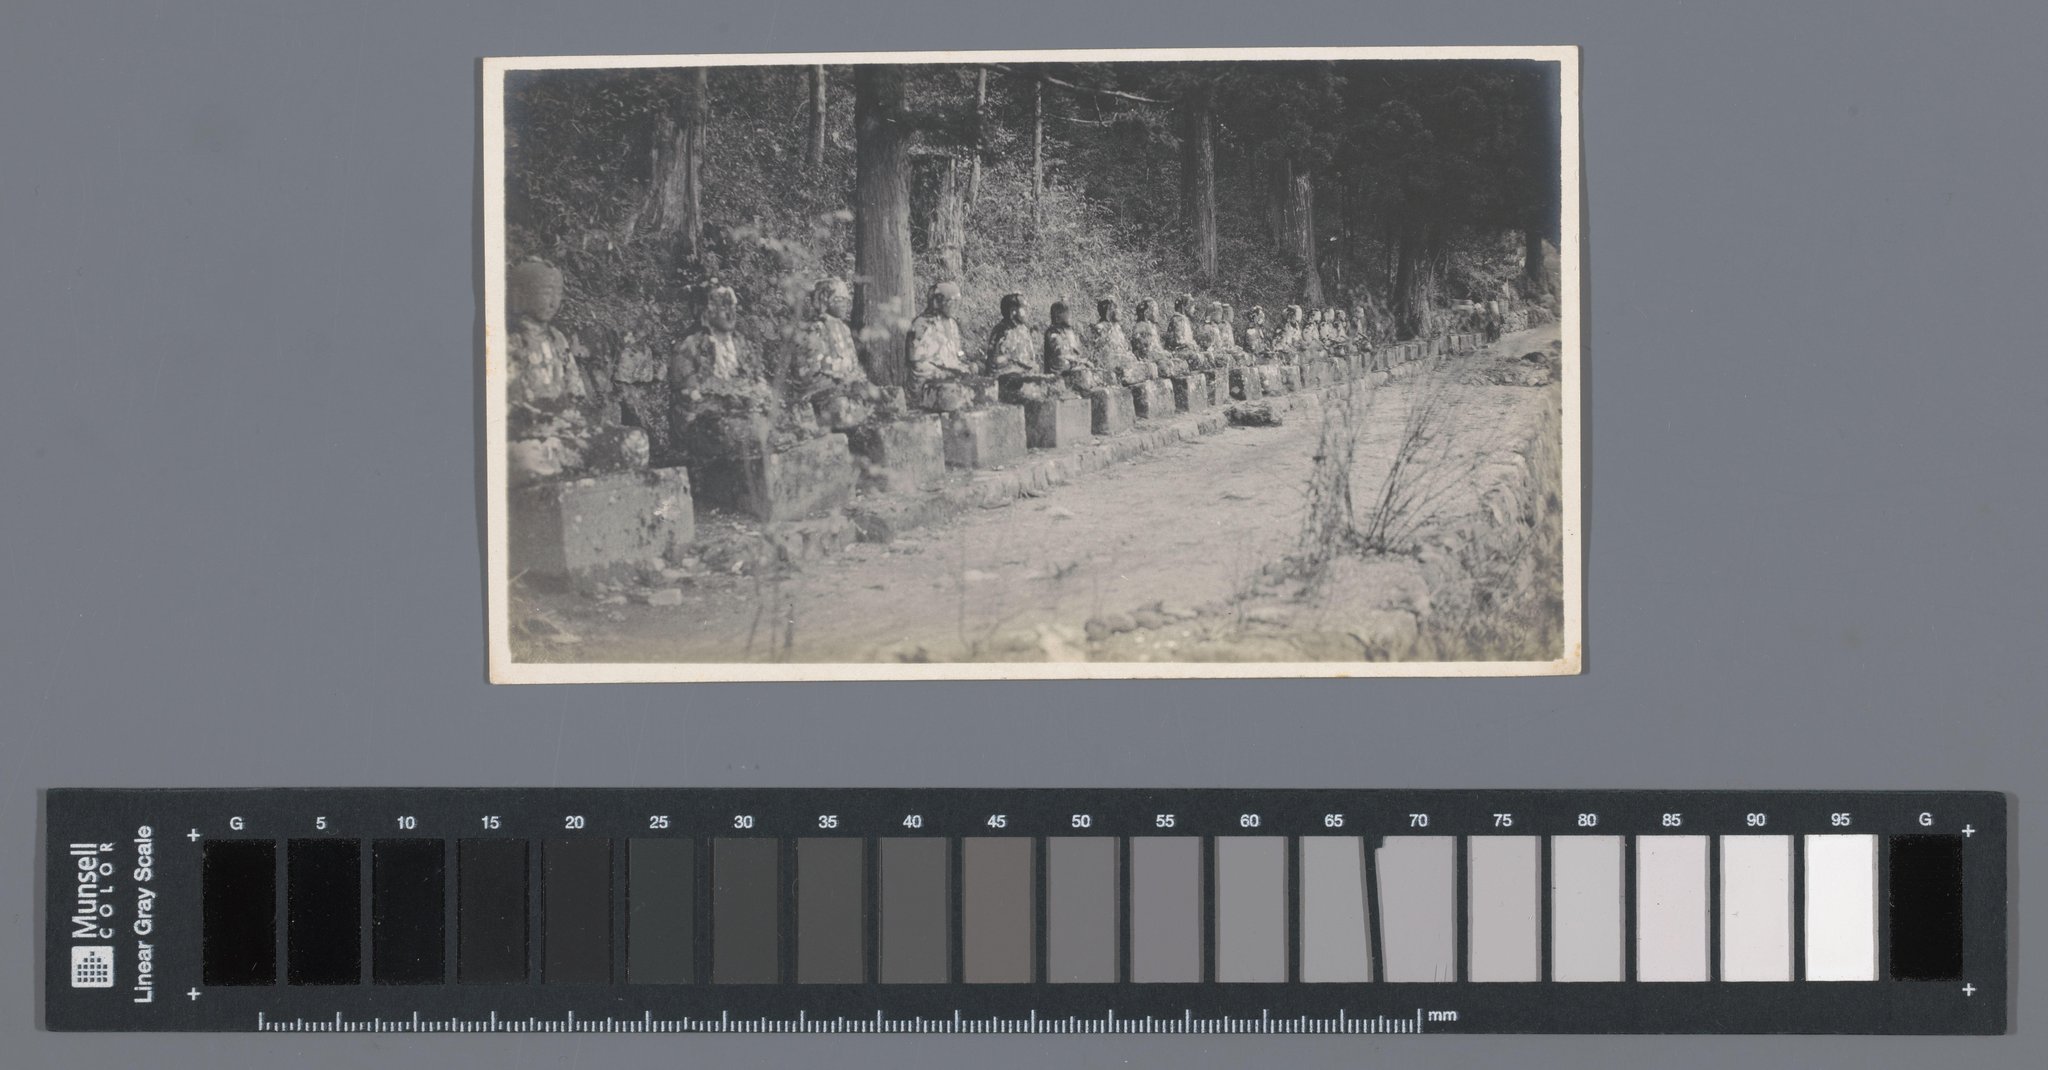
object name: photograph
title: Een rij beelden (boeddha?), Toshogu heiligdom, Nikko, Japan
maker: jan adriani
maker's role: fotograaf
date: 1907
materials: paper, photographic support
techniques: gelatin silver print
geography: japan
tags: gallery of sculptures